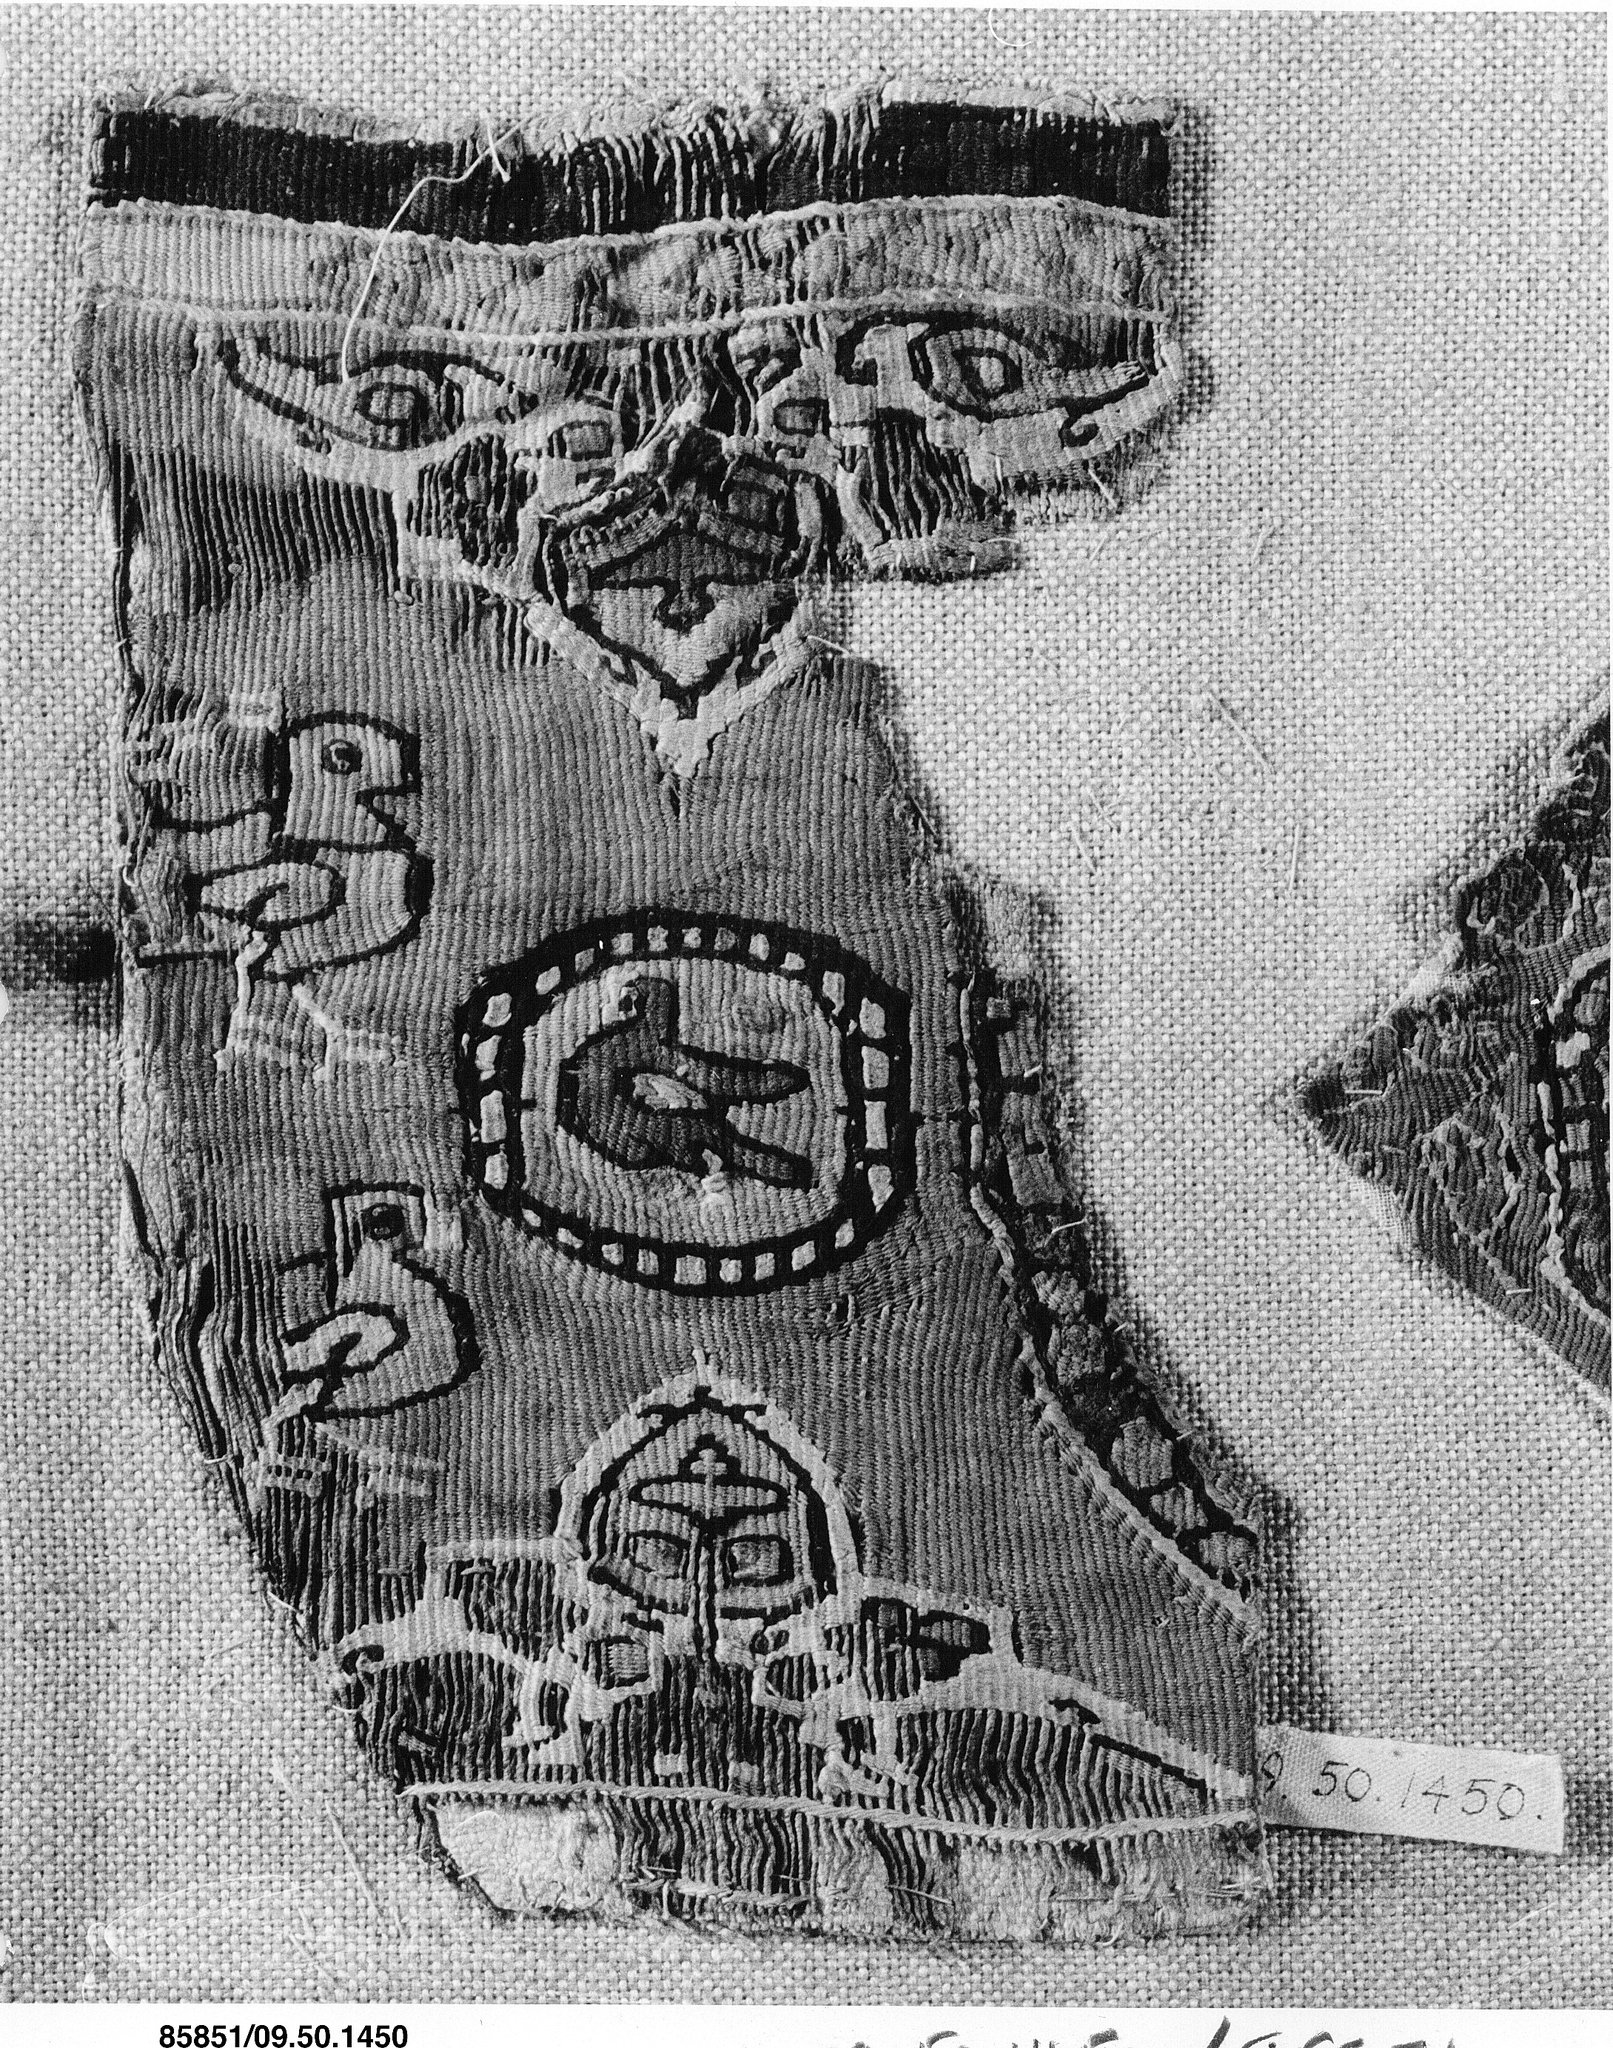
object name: band fragment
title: Fragment of a Band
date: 501-700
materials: linen, wool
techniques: weave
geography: egypt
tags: birds